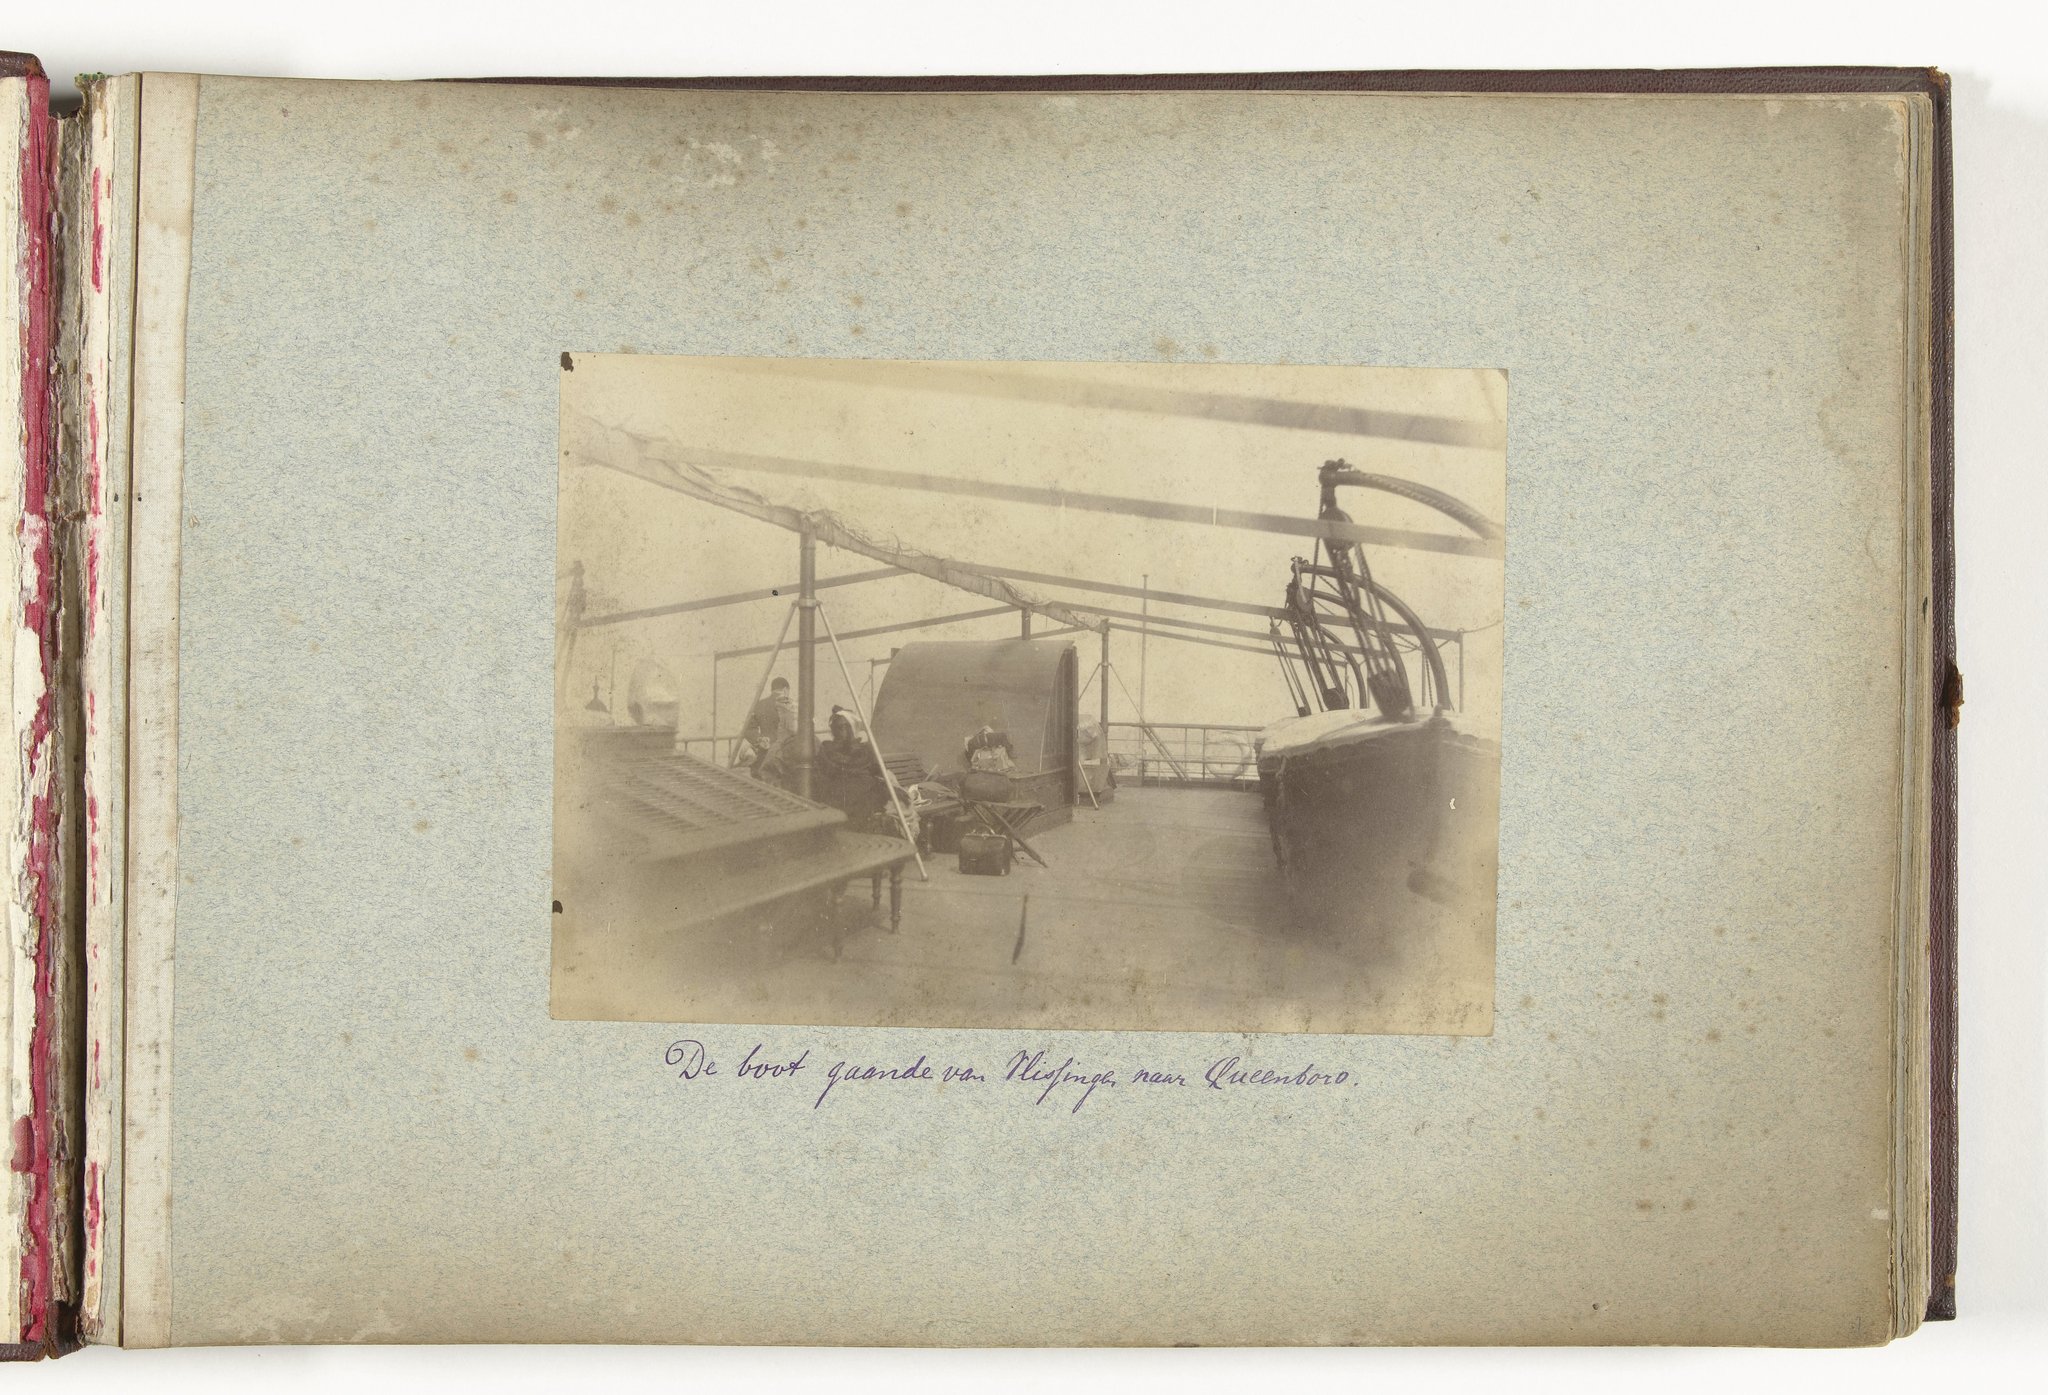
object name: album leaf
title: Dek van de boot tussen Vlissingen en Queensborough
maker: henry pauw van wieldrecht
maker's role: fotograaf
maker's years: 1863-1912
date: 1889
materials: cardboard, paper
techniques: albumen print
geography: north sea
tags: parts of ship's exterior: deck